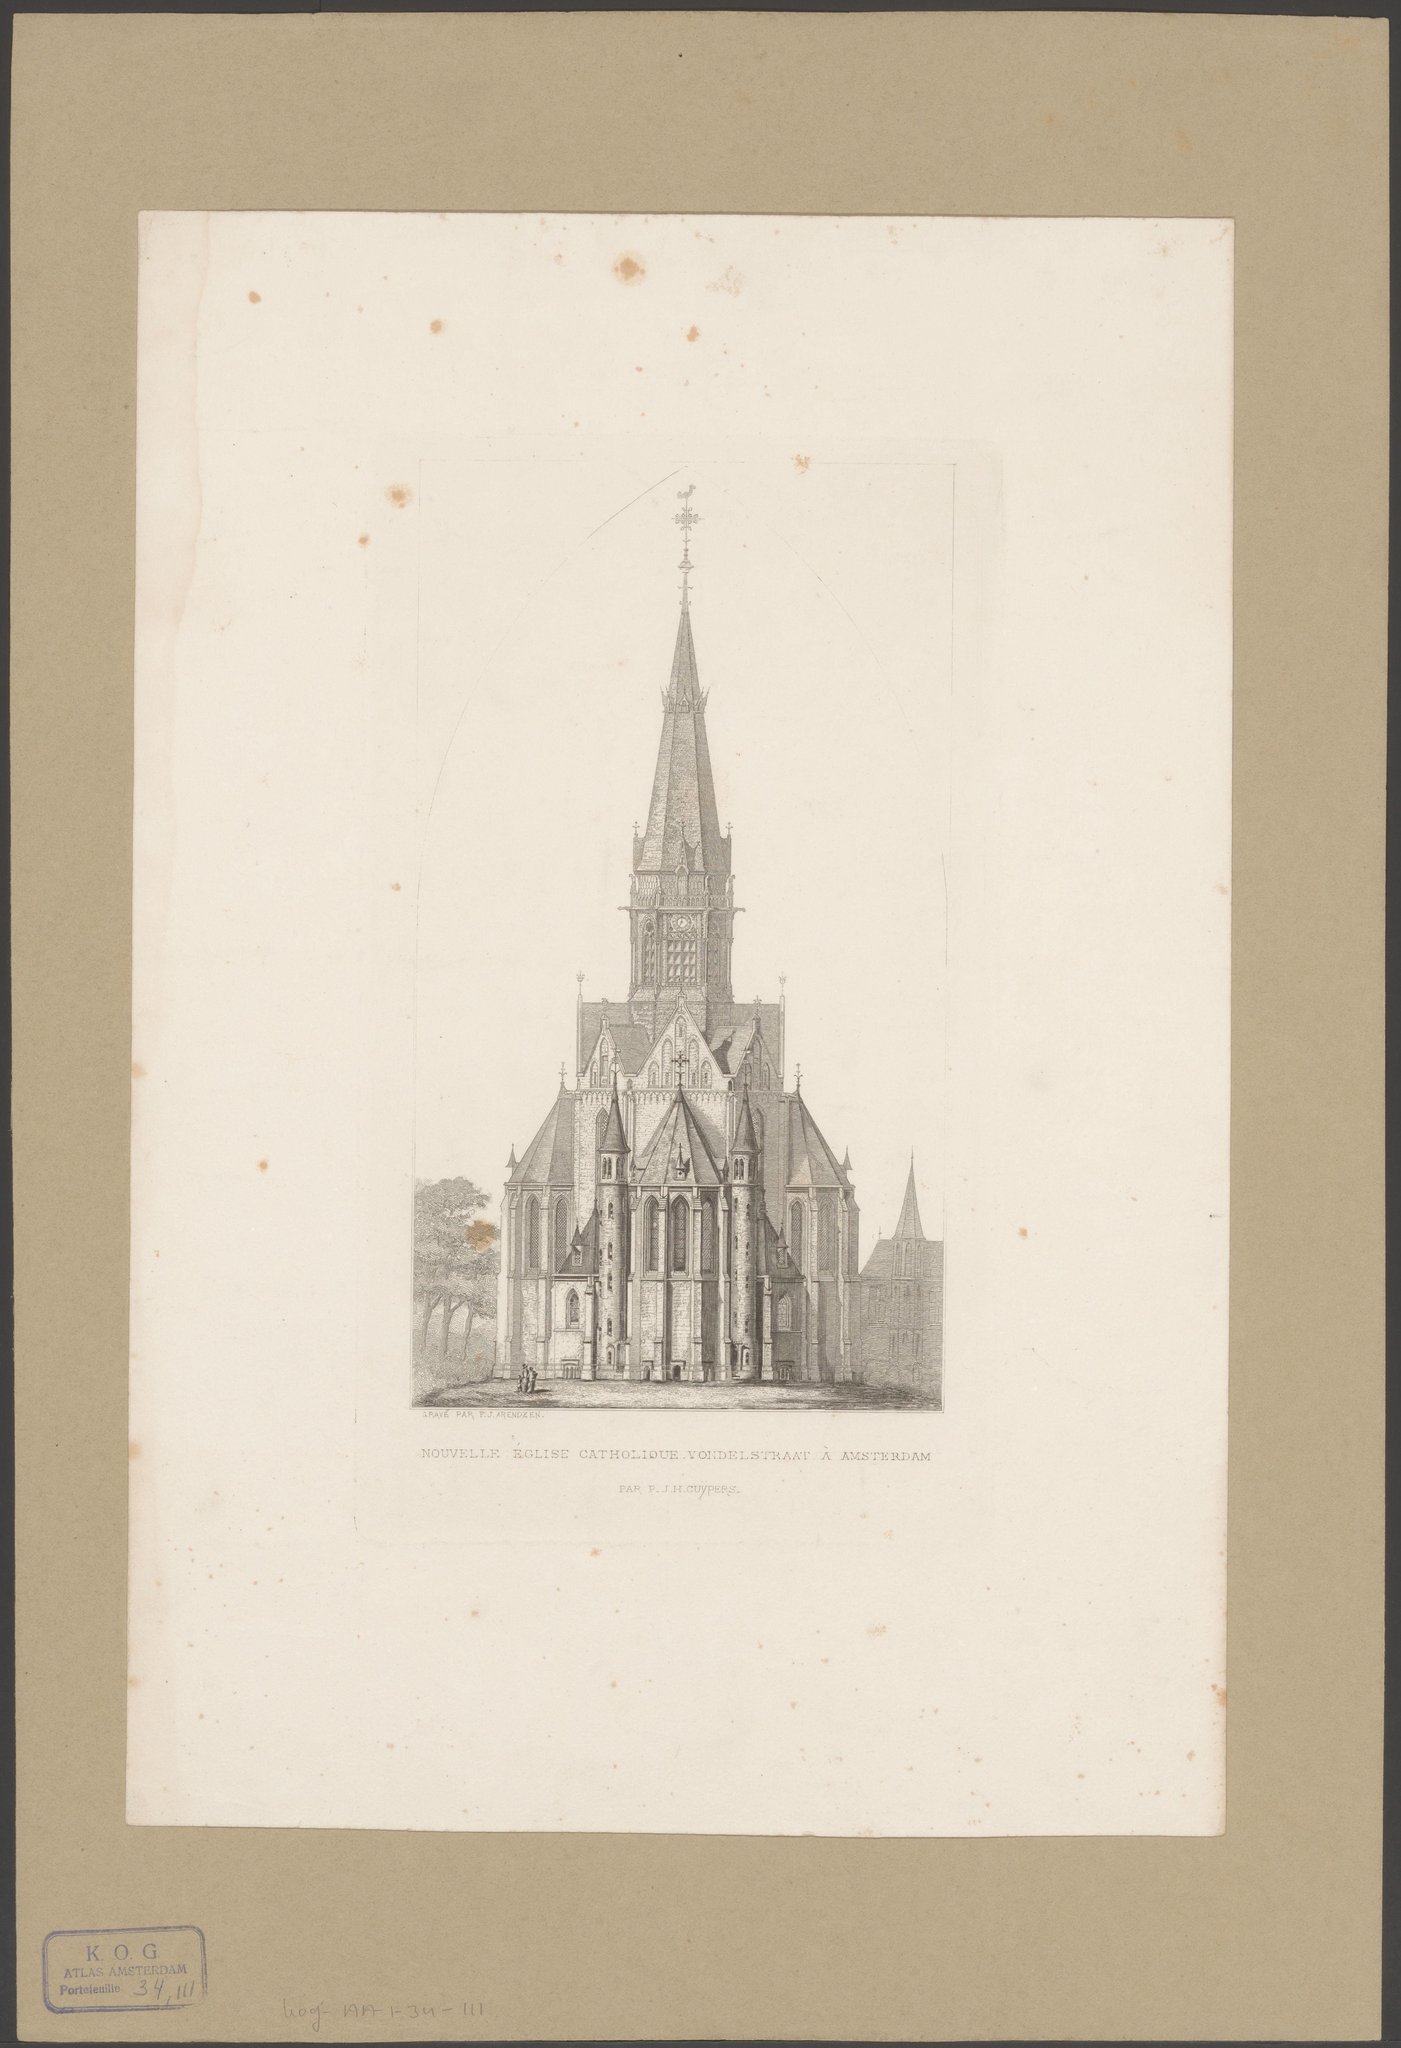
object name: print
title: Gezicht op de oostzijde van de Vondelkerk te Amsterdam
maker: petrus johannes arendzen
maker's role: draughtsman, print maker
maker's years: 1846-1932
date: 1880-1887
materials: paper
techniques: etching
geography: netherlands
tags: church (exterior)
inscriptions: collector's mark: Lugt 1641b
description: Onderwerpsrubriek binnen de Atlas Amsterdam: Kerkwezen: R.K. Gemeenten: Begijnhof t/m Petrus en Paulus.